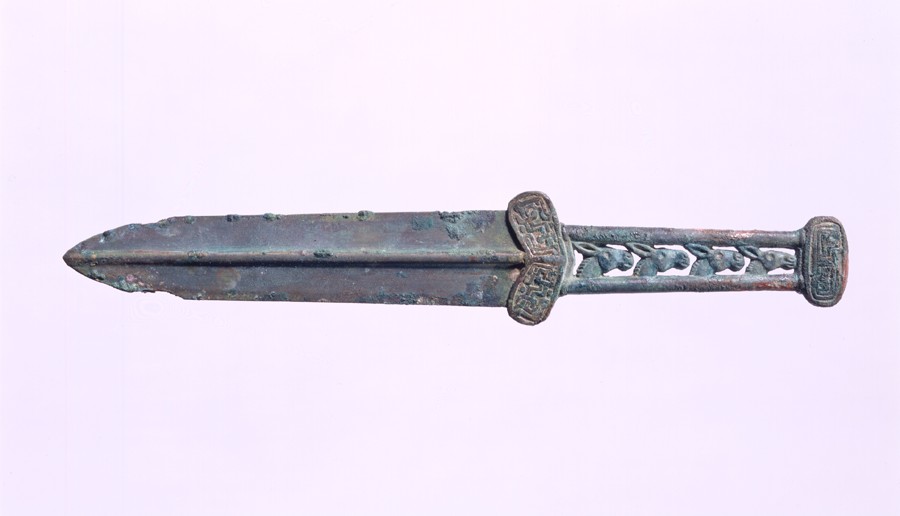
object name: sword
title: Short Sword with Four Kulans' Heads on the Handle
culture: chinese, northeast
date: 1000-701 BCE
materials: bronze